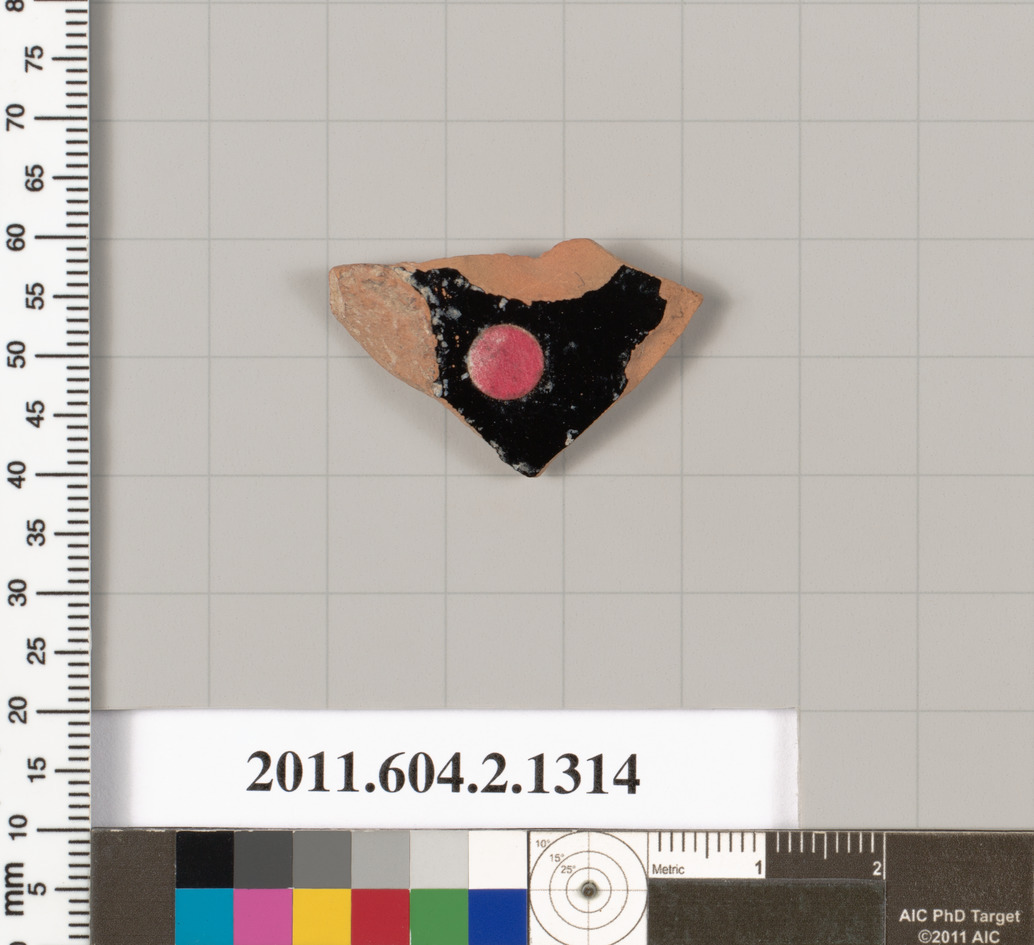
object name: skyphos fragment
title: Terracotta fragment of a skyphos (deep drinking cup)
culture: greek, attic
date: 600-401 BCE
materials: terracotta